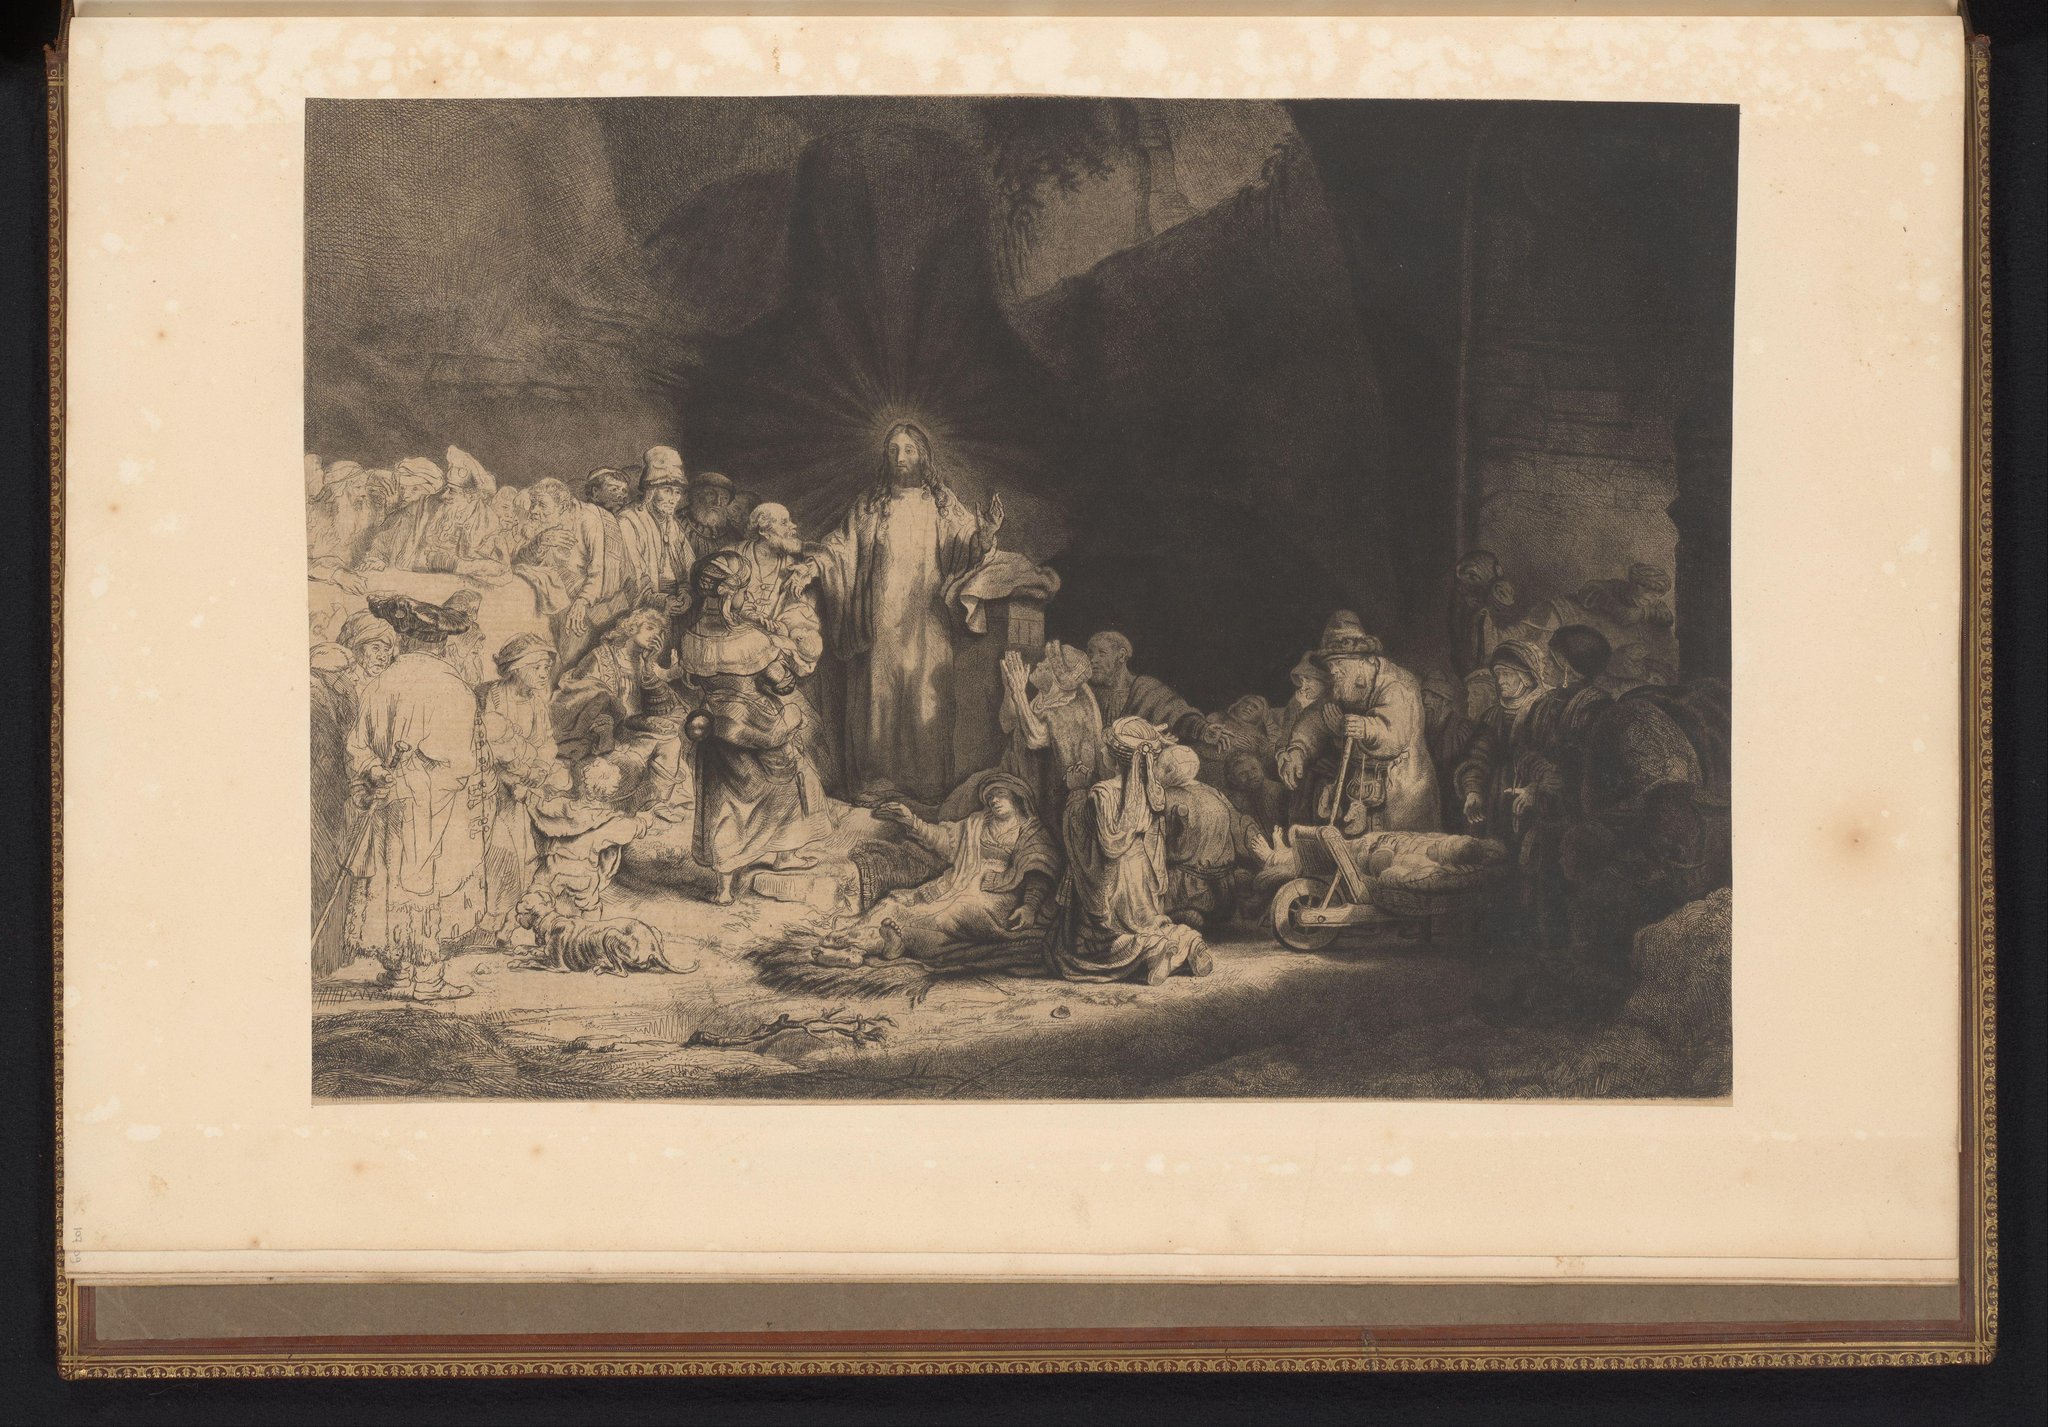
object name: print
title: Predikende Christus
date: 1753-1810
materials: paper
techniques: drypoint, etching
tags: christ preaching in the open